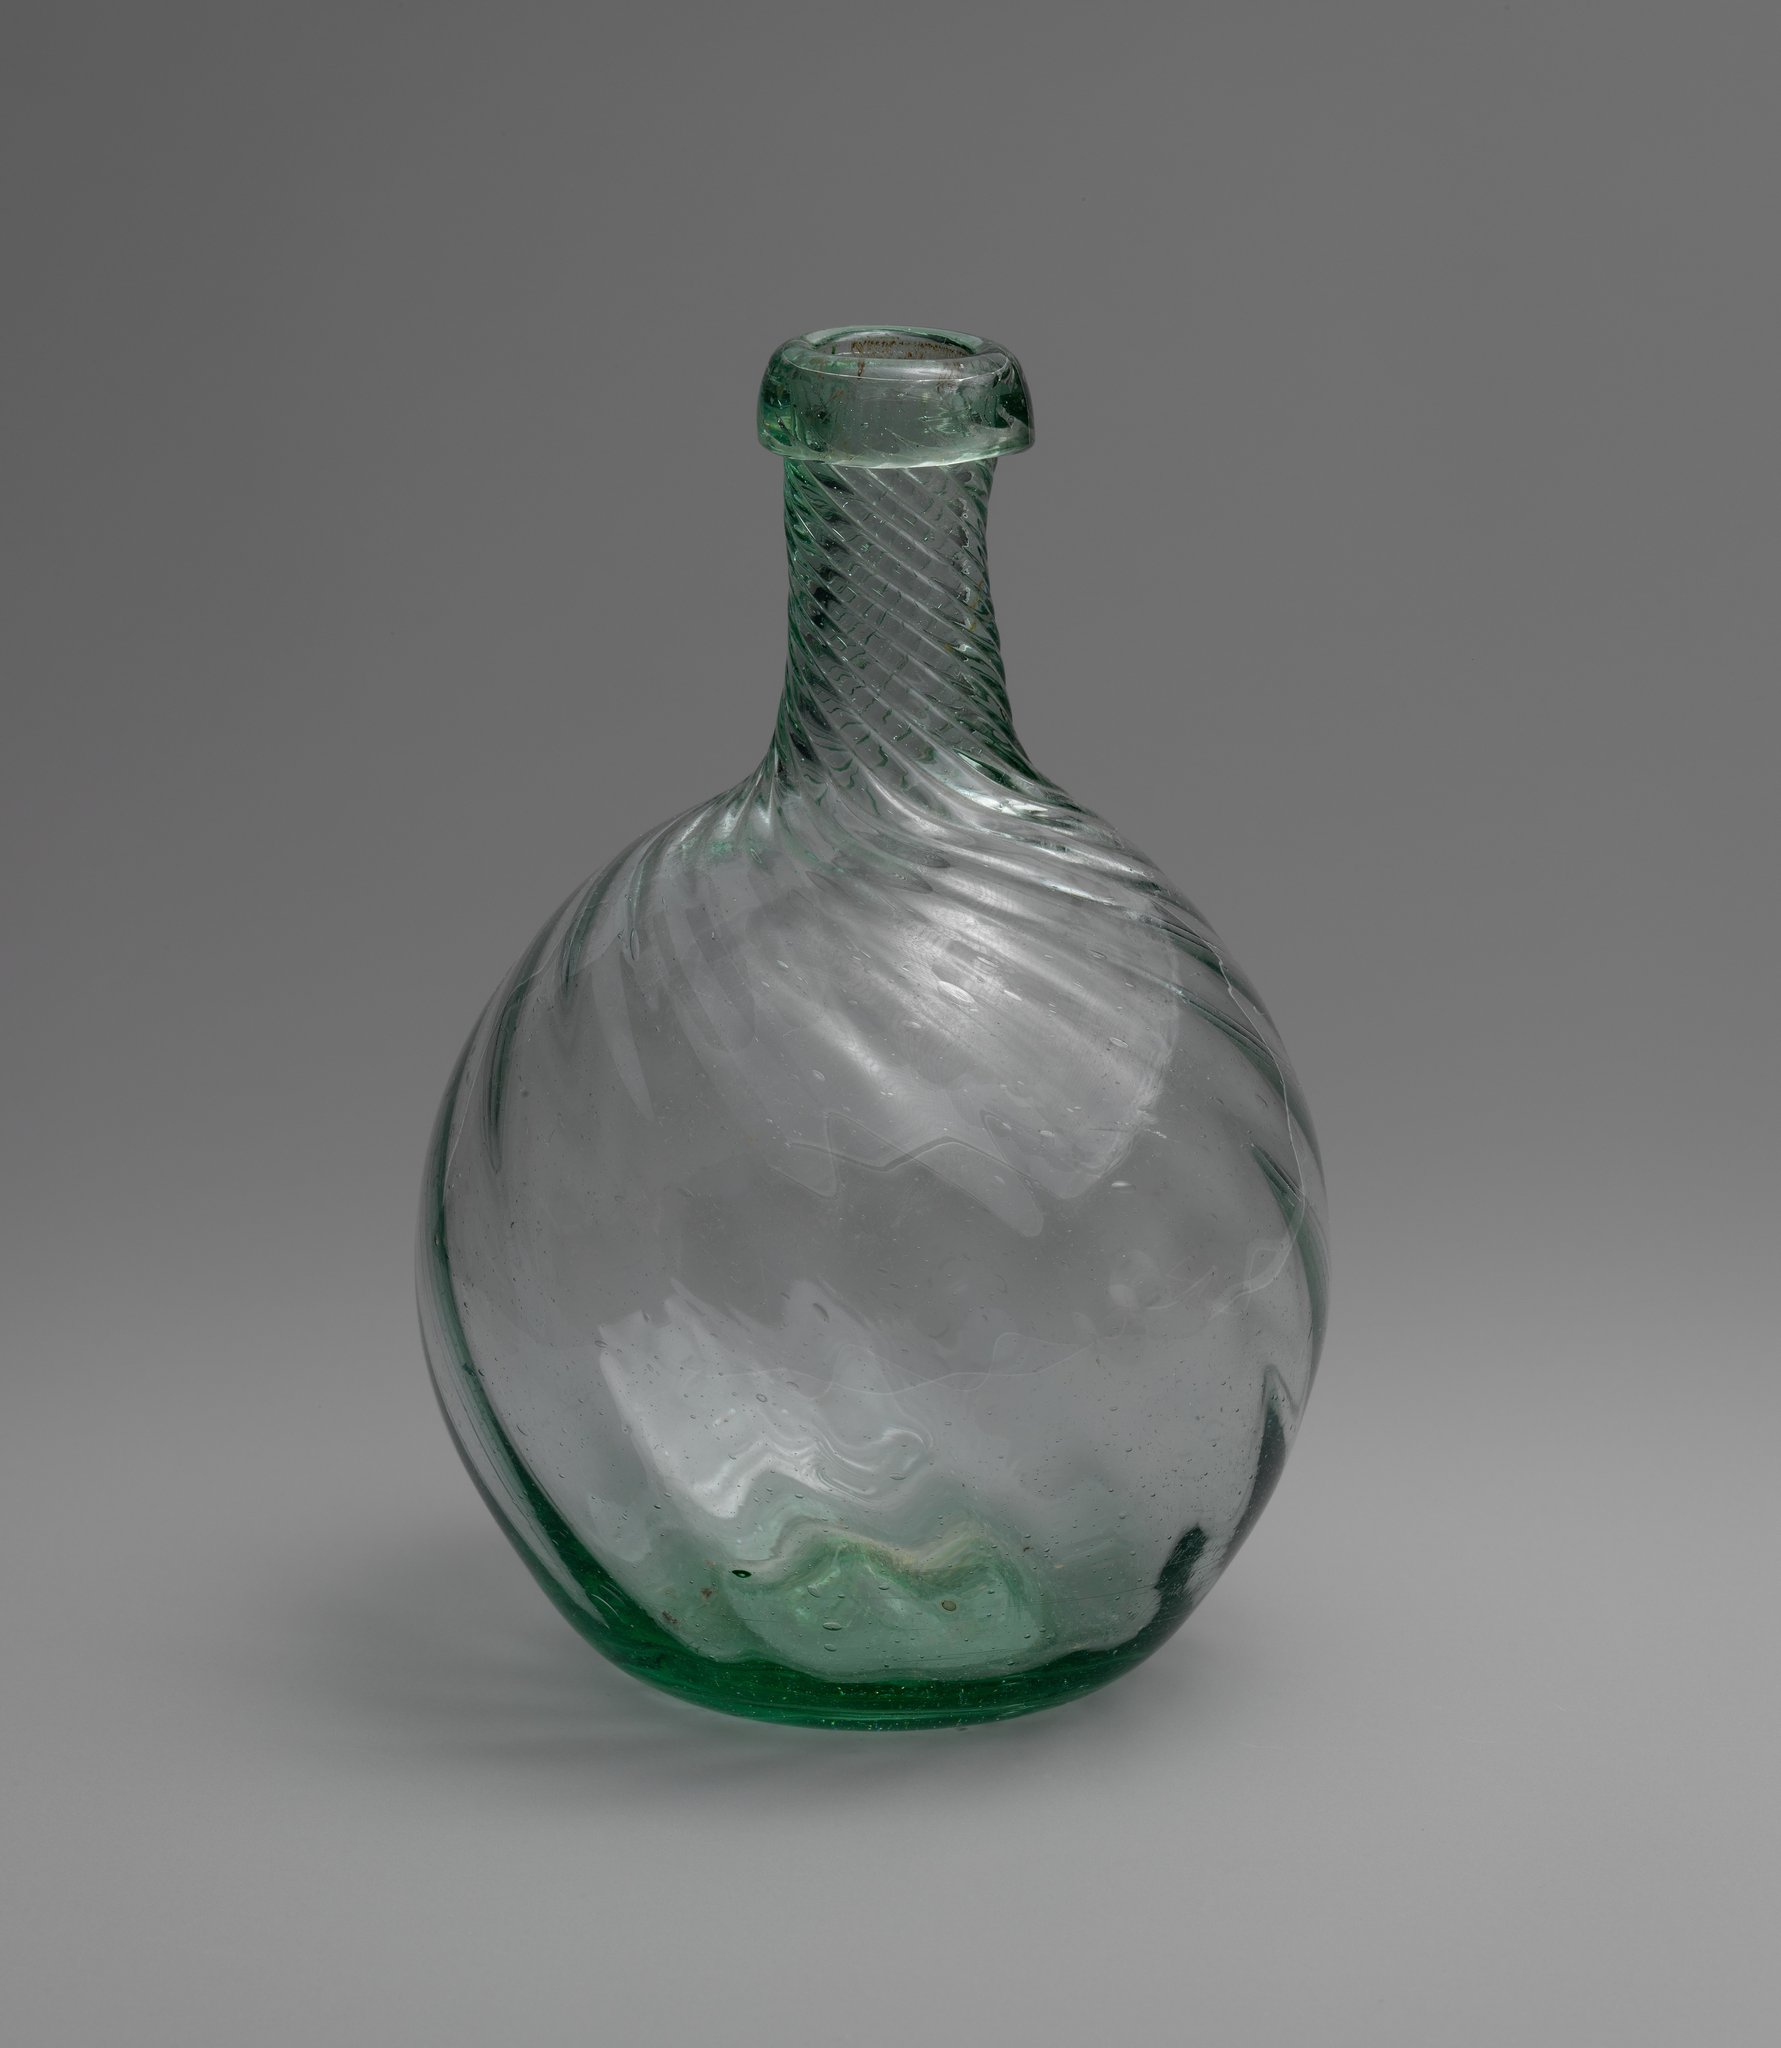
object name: bottle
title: "Calabash" bottle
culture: american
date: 1820-1850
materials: glass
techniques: glassblowing, molding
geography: united states